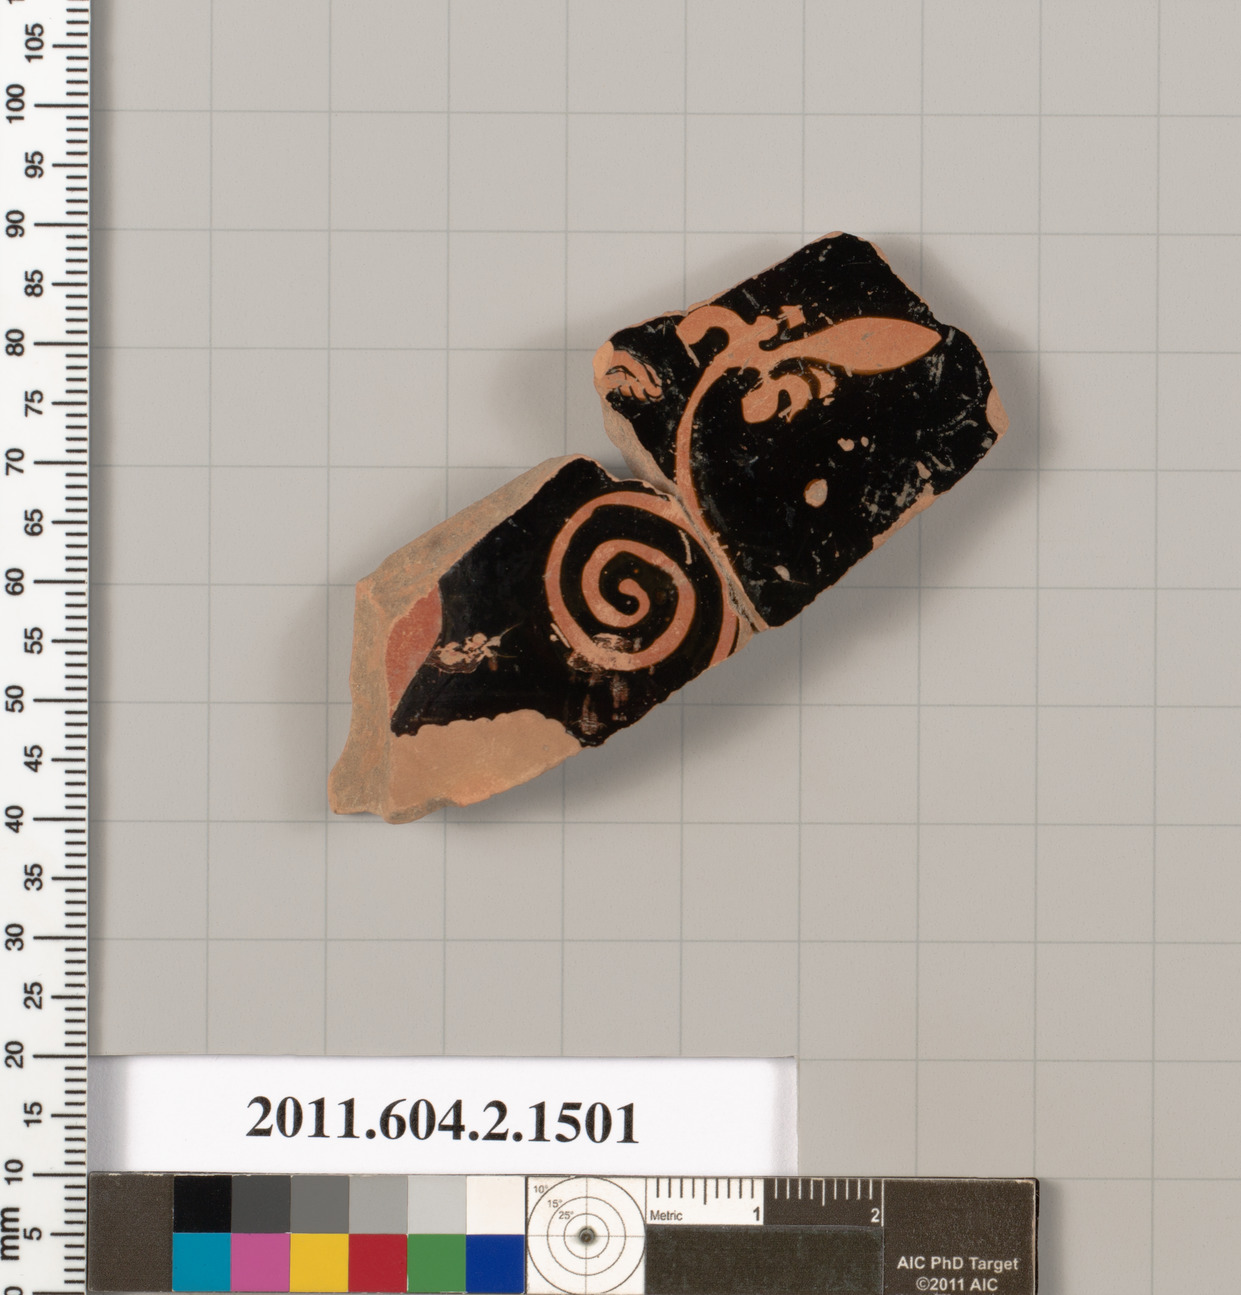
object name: skyphos fragment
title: Terracotta fragment of a skyphos (deep drinking cup)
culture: greek, attic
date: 460-440 BCE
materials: terracotta